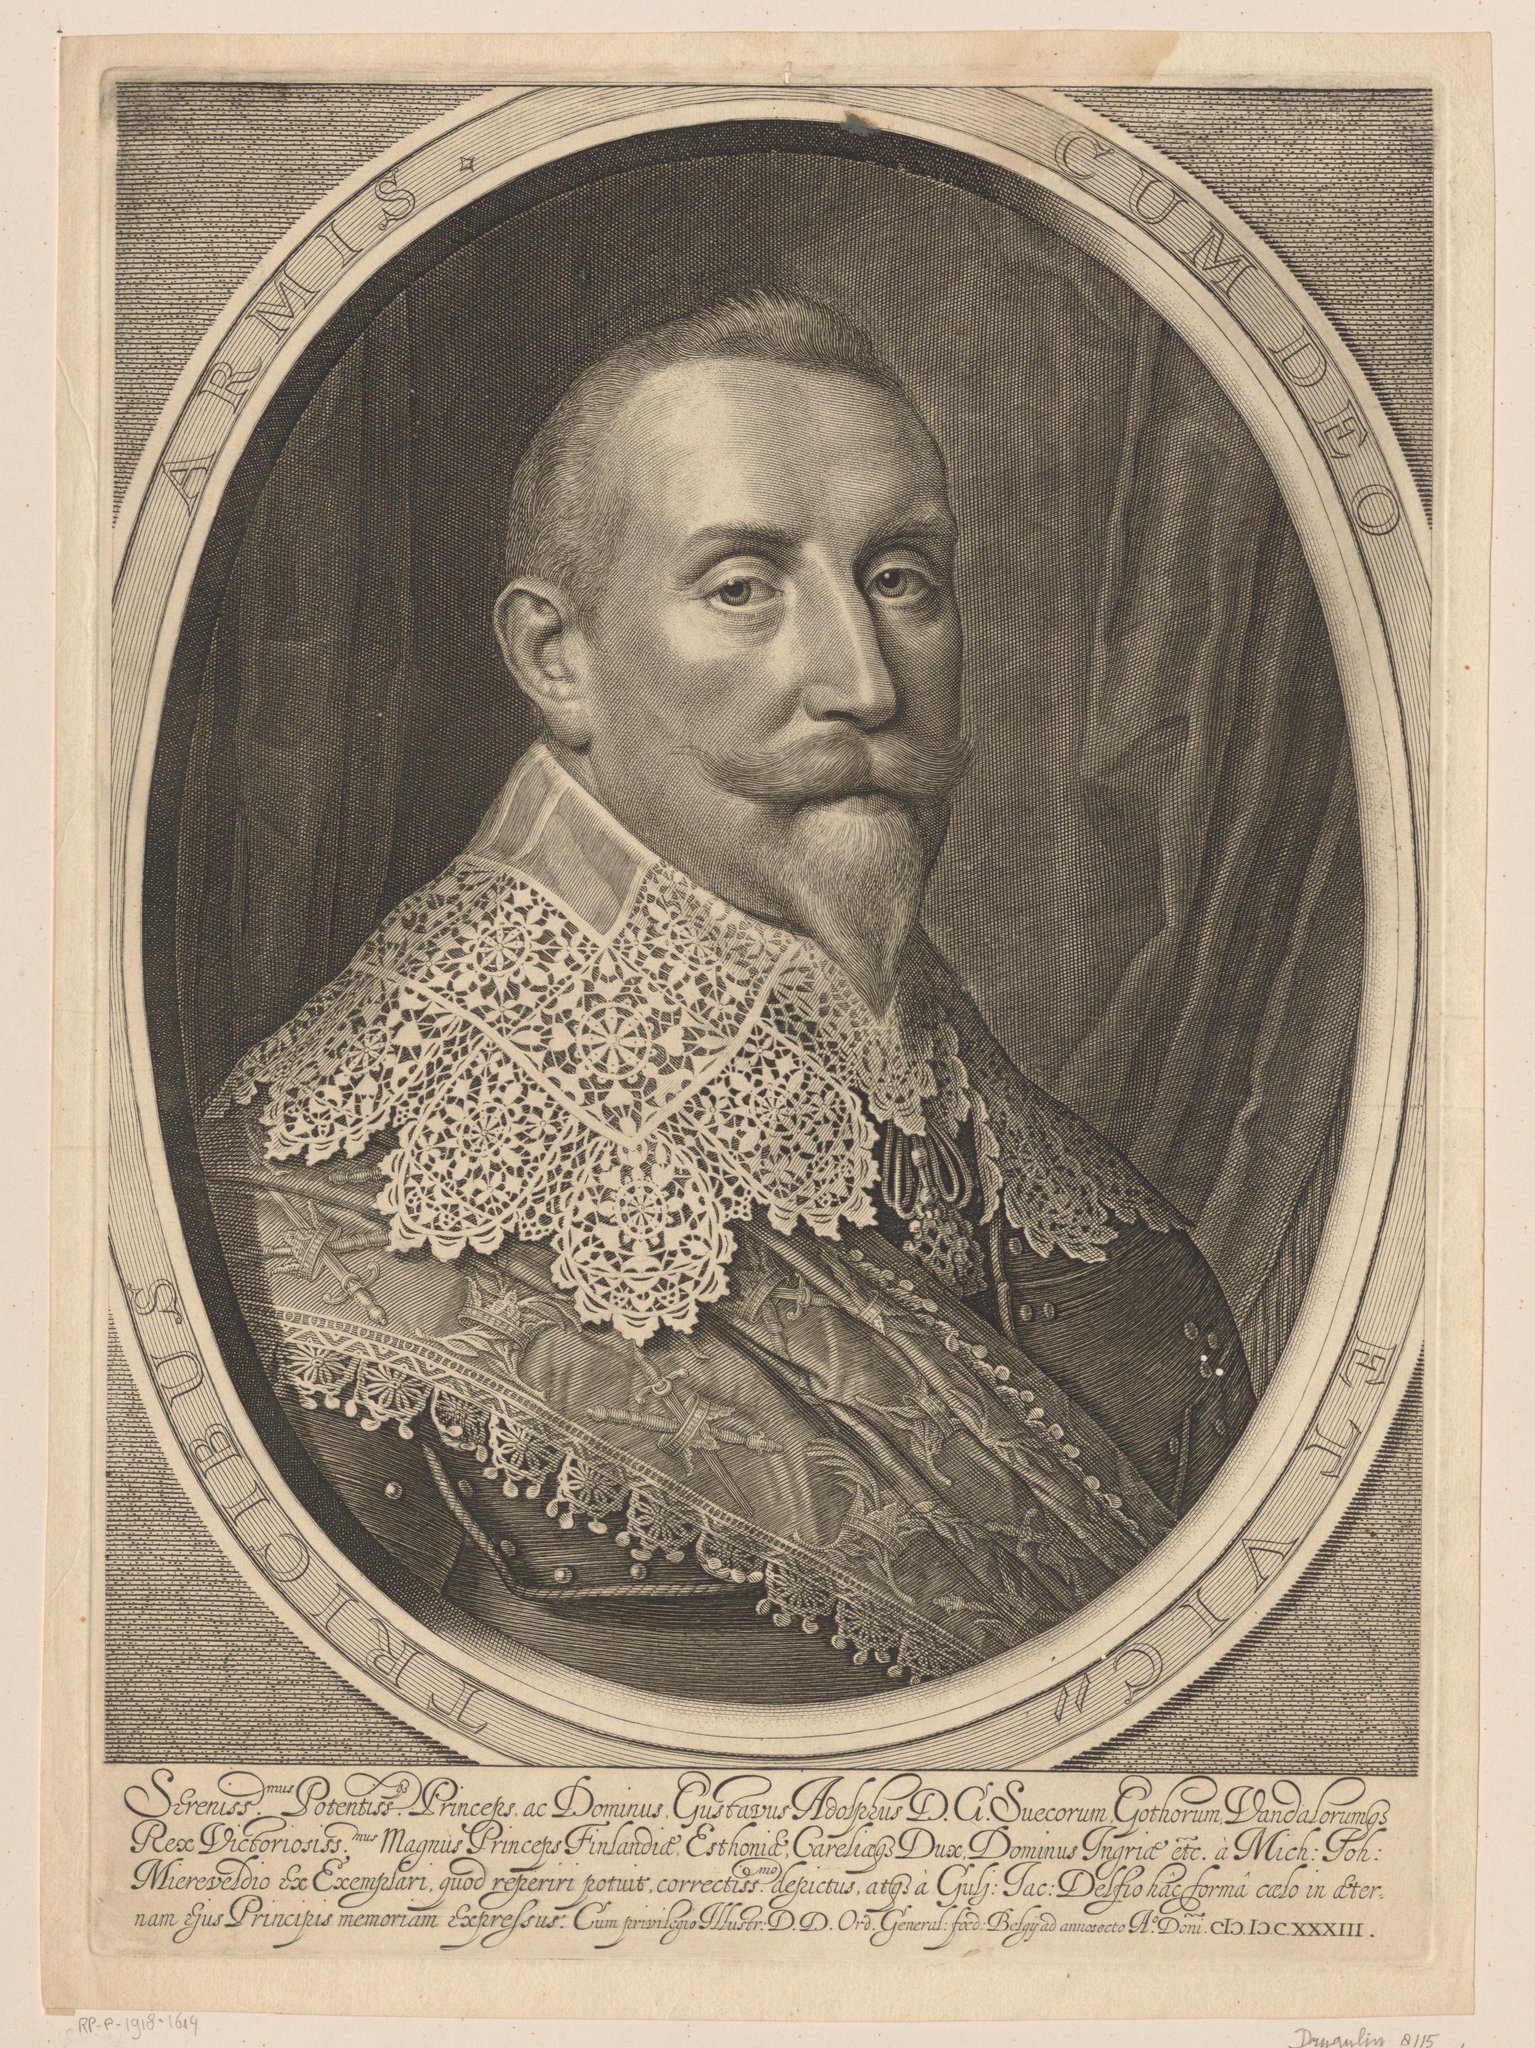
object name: print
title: Portret van Gustaaf II Adolf, koning van Zweden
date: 1633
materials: paper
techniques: engraving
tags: historical persons, king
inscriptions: collector's mark: Lugt 2233